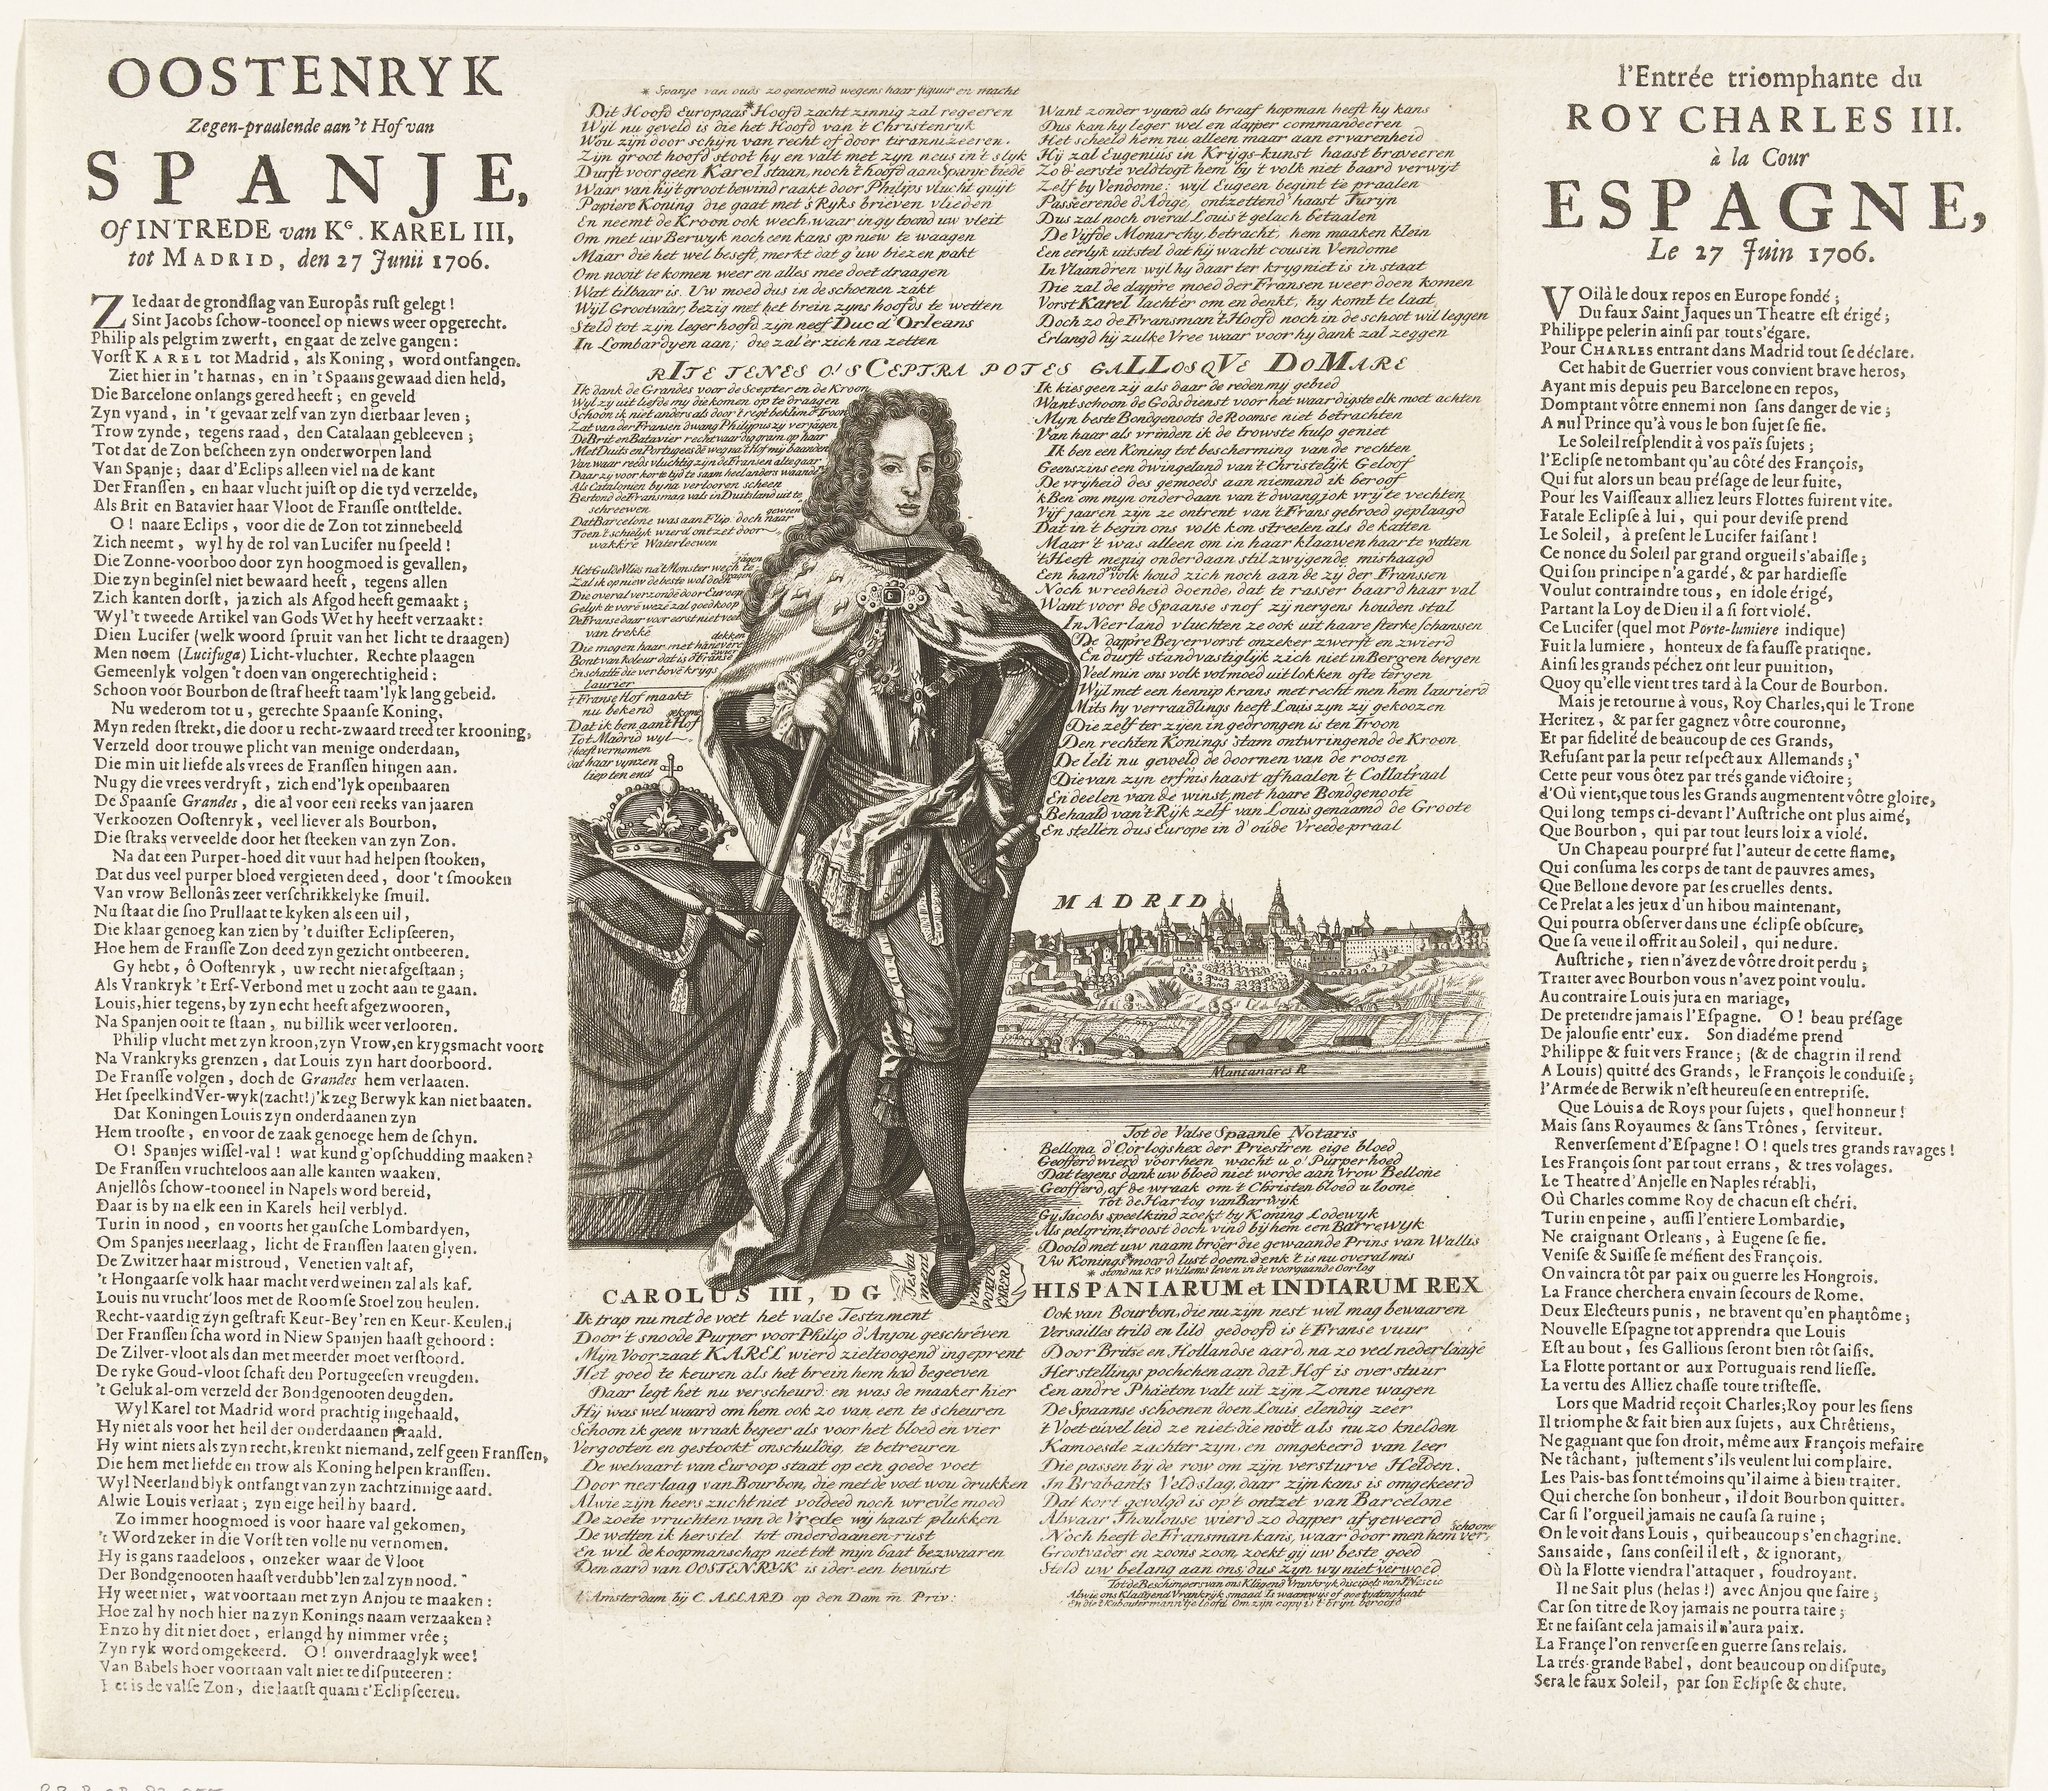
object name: print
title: Oostenryk Zegen-praalende aan 't Hof van Spanje. Of Intrede van Kg. Karel III, tot Madrid, den 27 Junii 1706 / l'Entrée triomphante du Roy Charles III. à la Cour Espagne, Le 27. Juin 1706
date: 1706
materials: paper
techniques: etching, letterpress printing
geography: amsterdam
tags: vienna, charles vi (holy roman emperor)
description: Aartshertog Karel van Oostenrijk als Karel III, koning van Spanje, staande ten voeten uit in wapenrusting met mantel en commandostaf, 1706. Op de achtergrond Madrid waar de koning op 27 juni intocht hield. In de plaat verzen in het Nederlands, op het blad gedrukt twee kolommen tekst in Nederlands en Frans. Spotprent op de situatie in het jaar 1706 in de Spaanse Successieoorlog. Onderdeel van een reeks van 25 spotprenten op de Fransen en bondgenoten uit het jaar 1706.